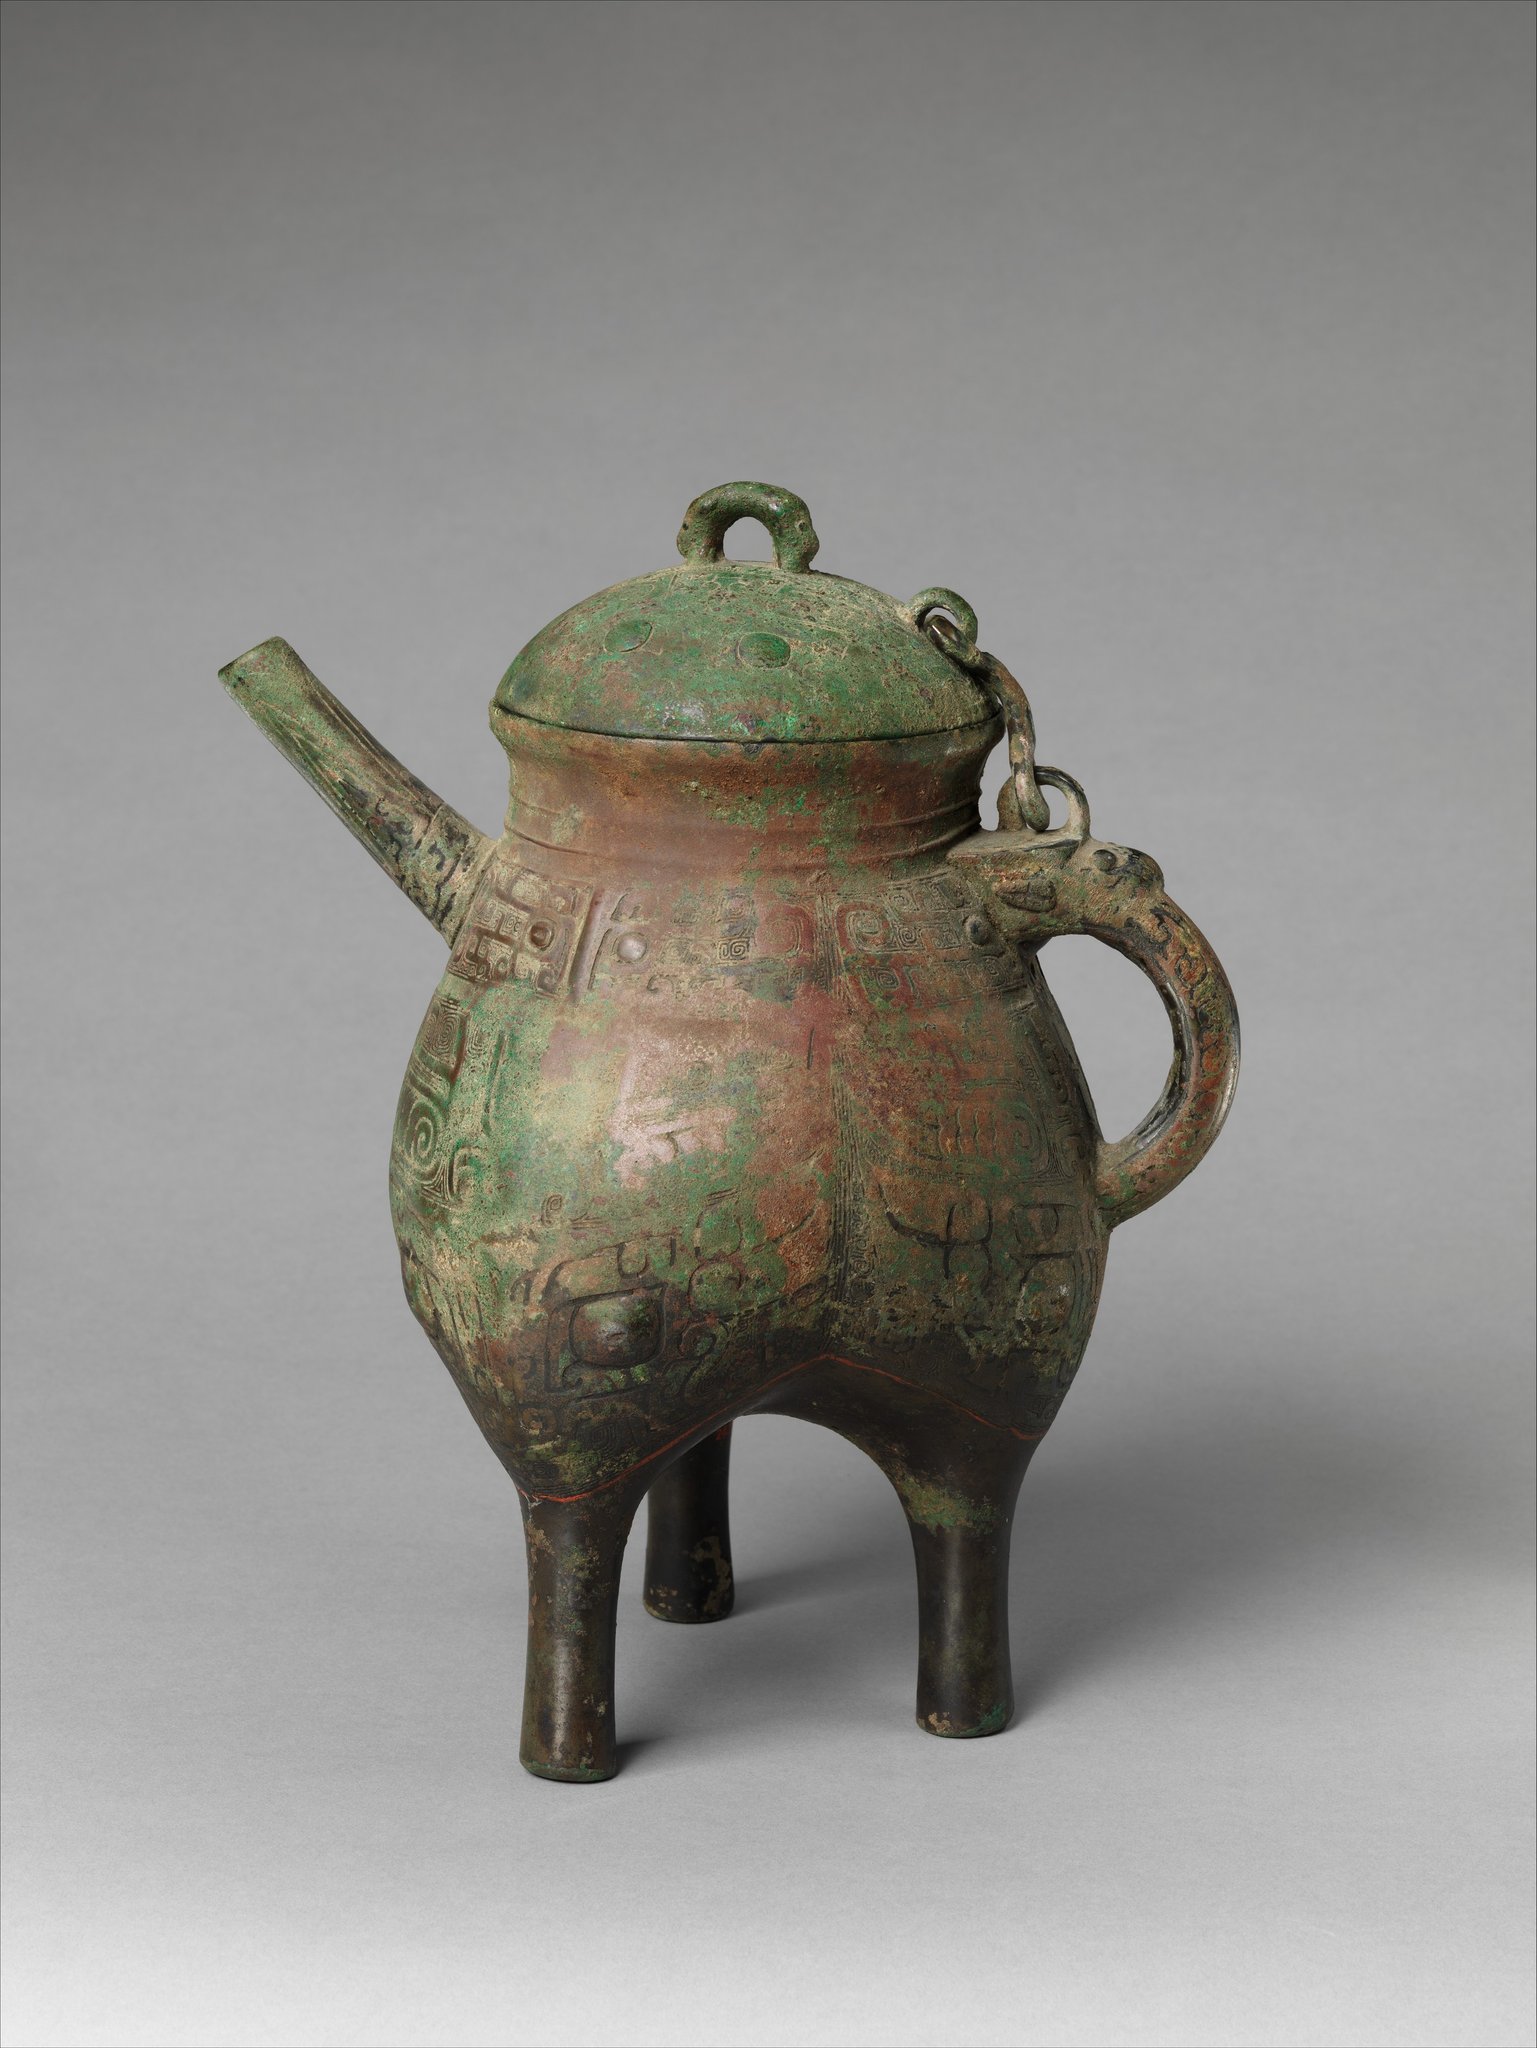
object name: water vessel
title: Spouted Ritual Water Vessel (He) with Attached Lid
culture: chinese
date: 1034-1001 BCE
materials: bronze